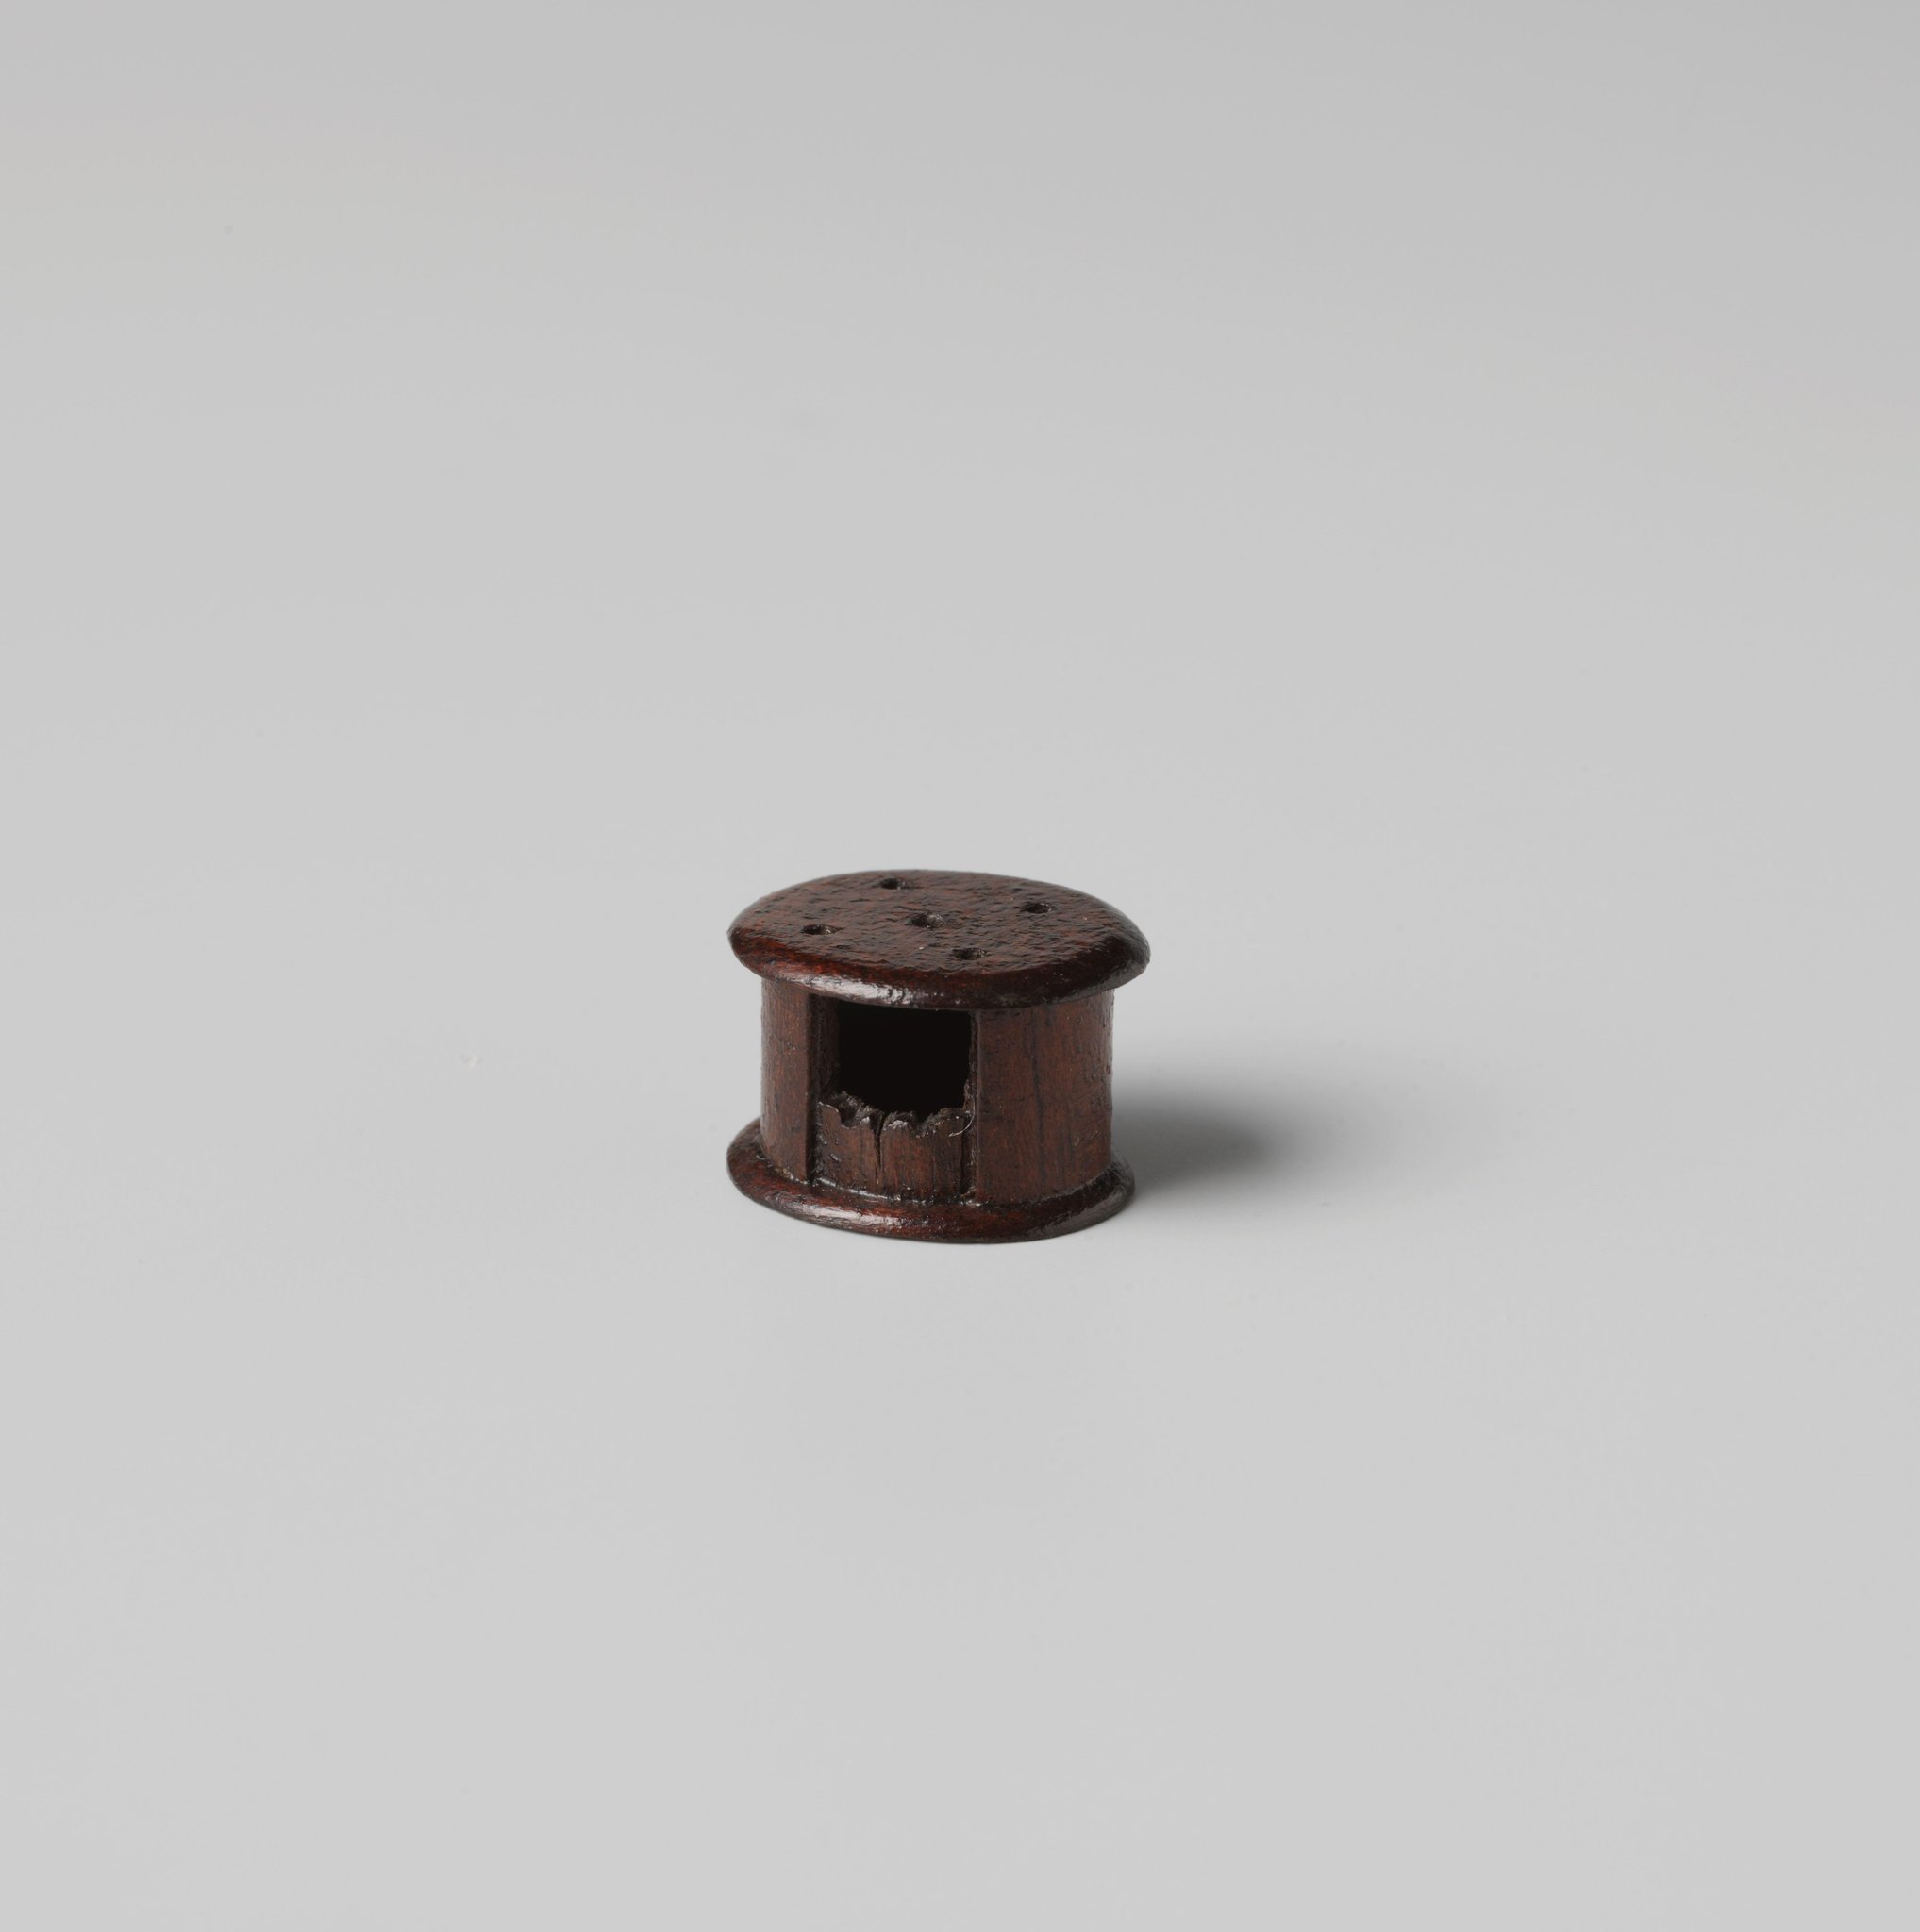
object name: miniature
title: Stoof, ovaal, met vijf gaten in de bovenzijde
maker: Anonymous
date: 1740-1760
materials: wood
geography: amsterdam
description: Stoof van mahoniehout, ovaal met in de bovenzijde vijf gaten, de opening voor de vuurtest is afgewerkt met een geschulpte voorregel.